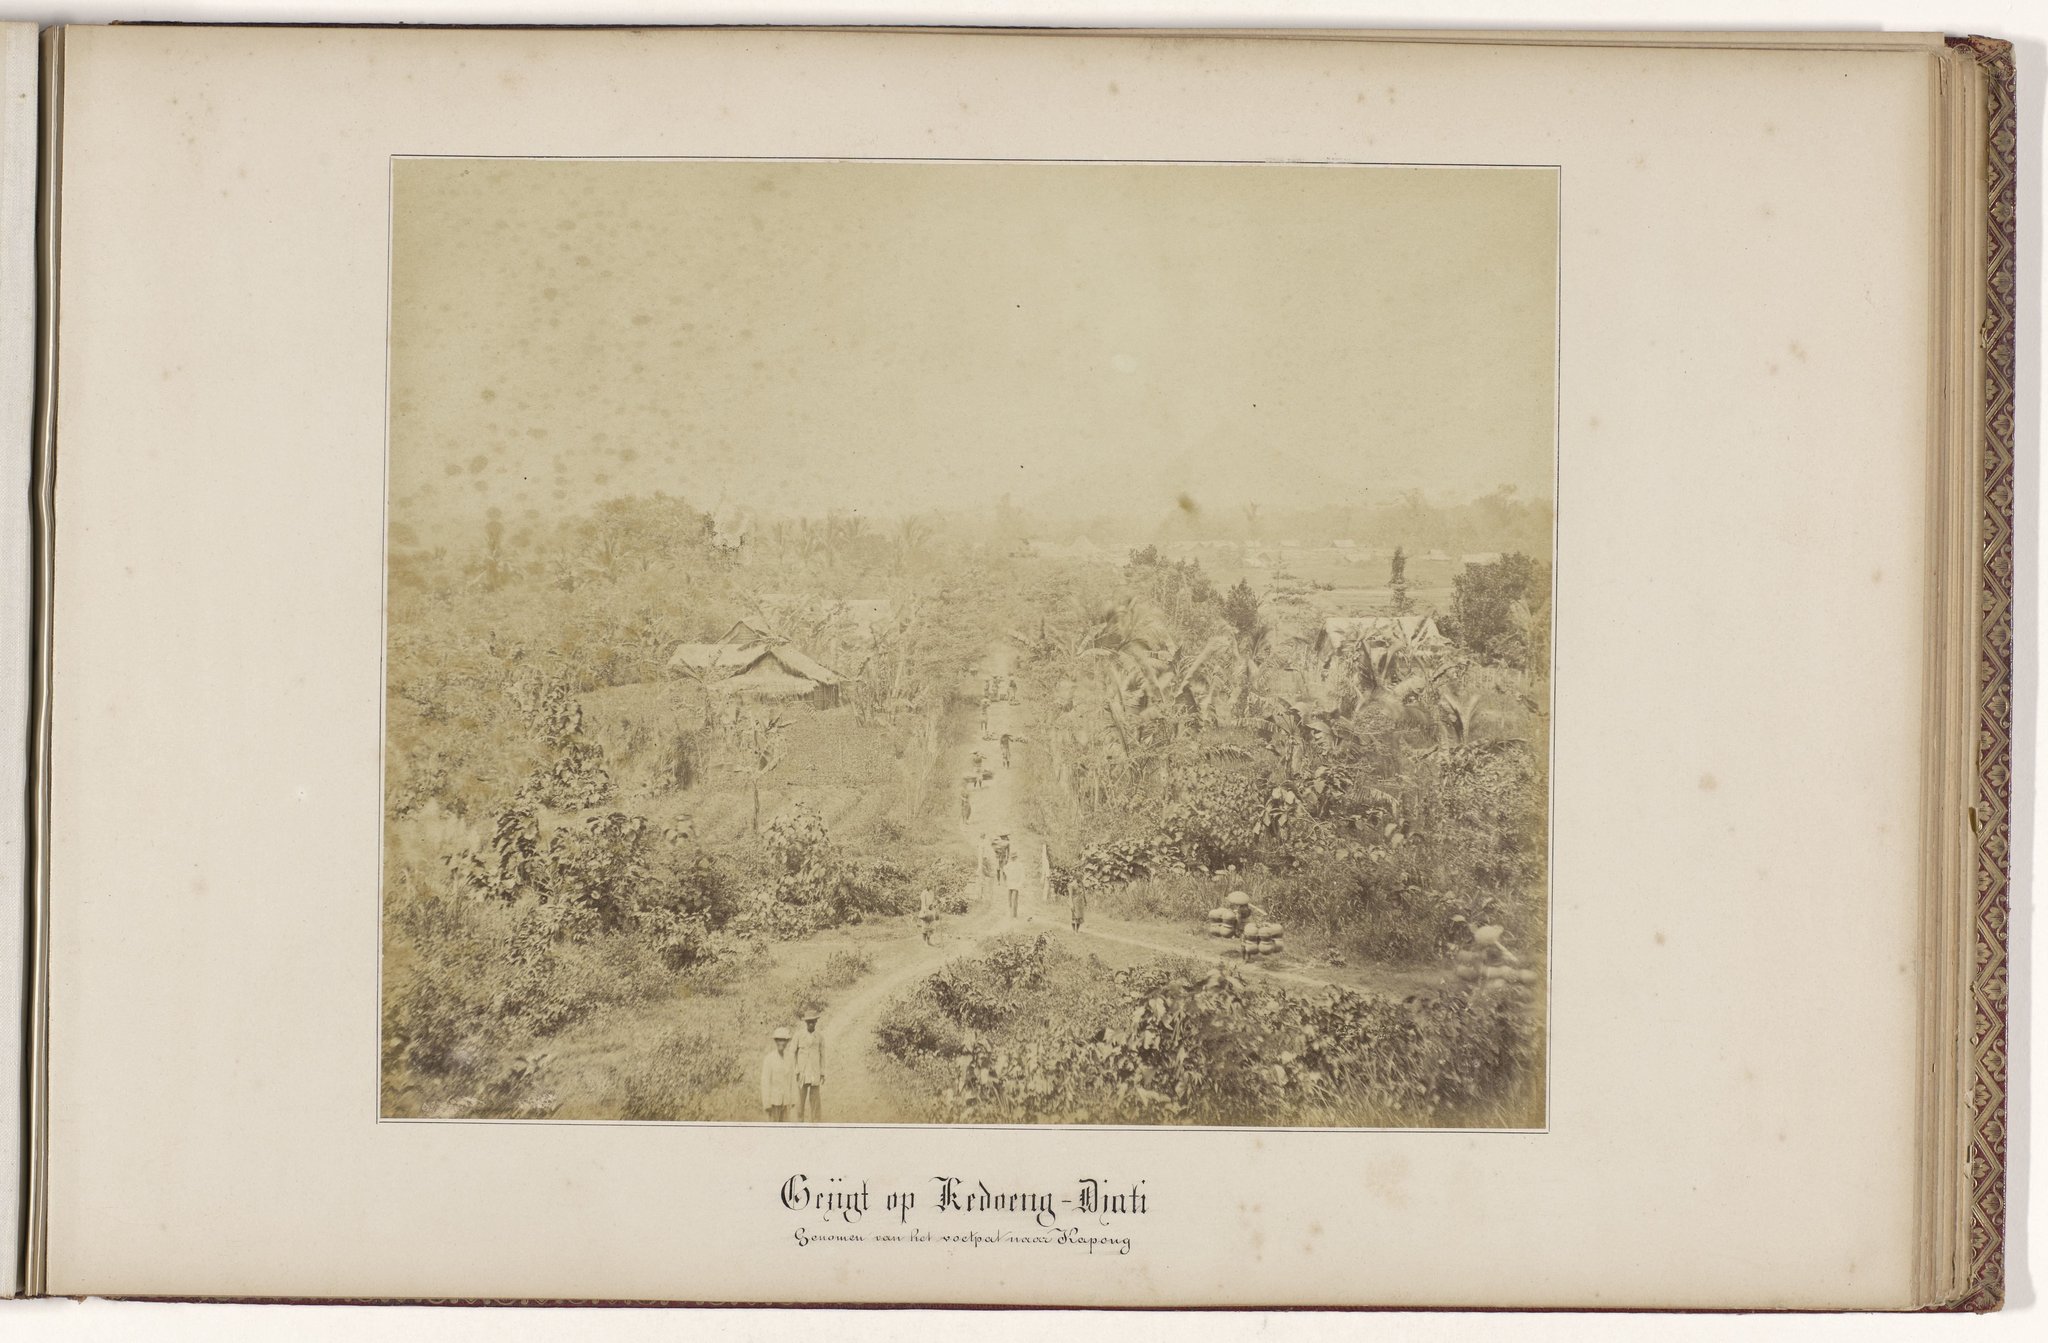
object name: album leaf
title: Gezigt bij Kedoeng-Djati / Genomen van het voetpat naar Kapong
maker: carl emanuel friedrich lang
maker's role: draughtsman, print maker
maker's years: -1906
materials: cardboard, photographic support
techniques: albumen print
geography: java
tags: colonial system, railway-traffic, building-site, java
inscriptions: signature and date: ‘C. Lang. Maart 1865’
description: Gezicht bij de plaats Kedoeng-Djatti met dragers en dorpelingen gaande over een voetpad. Albumblad met opgeplakte foto, onderdeel van het fotoalbum over de aanleg van de spoorlijn Semarang - Kedoeng Djattie (Kedungjati) op Java in 1865.